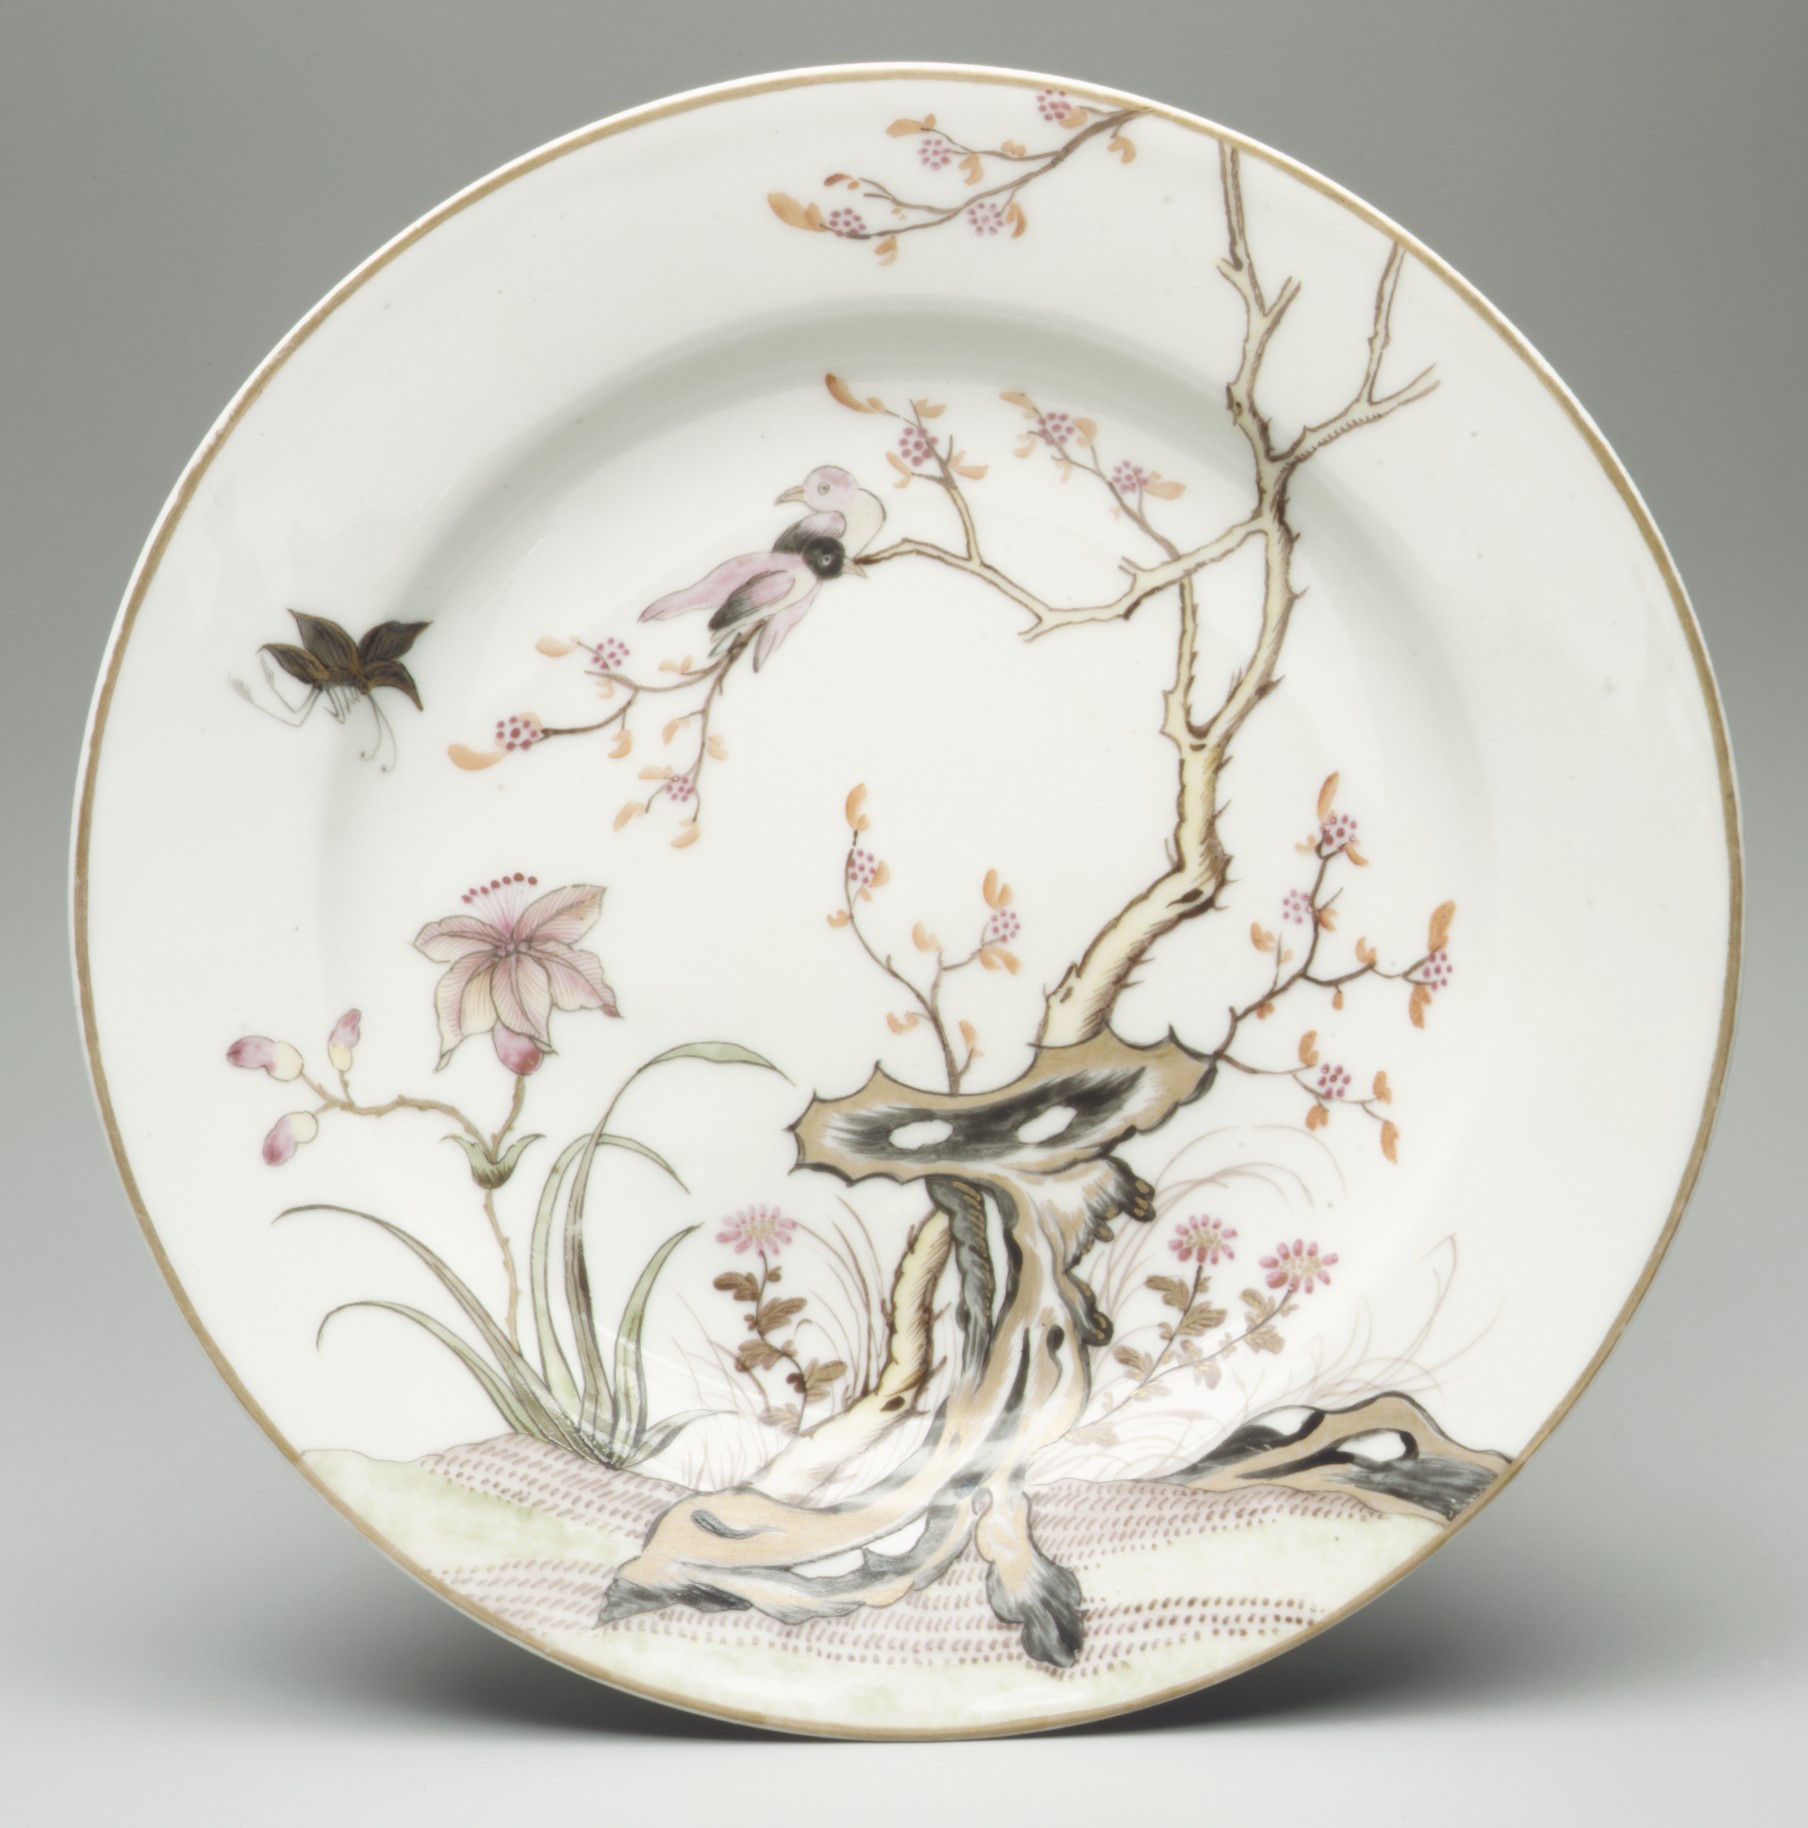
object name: plate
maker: zurich pottery and porcelain factory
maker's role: factory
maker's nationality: swiss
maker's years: 1763-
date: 1770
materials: hard paste porcelain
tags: birds,insects,flowers,trees